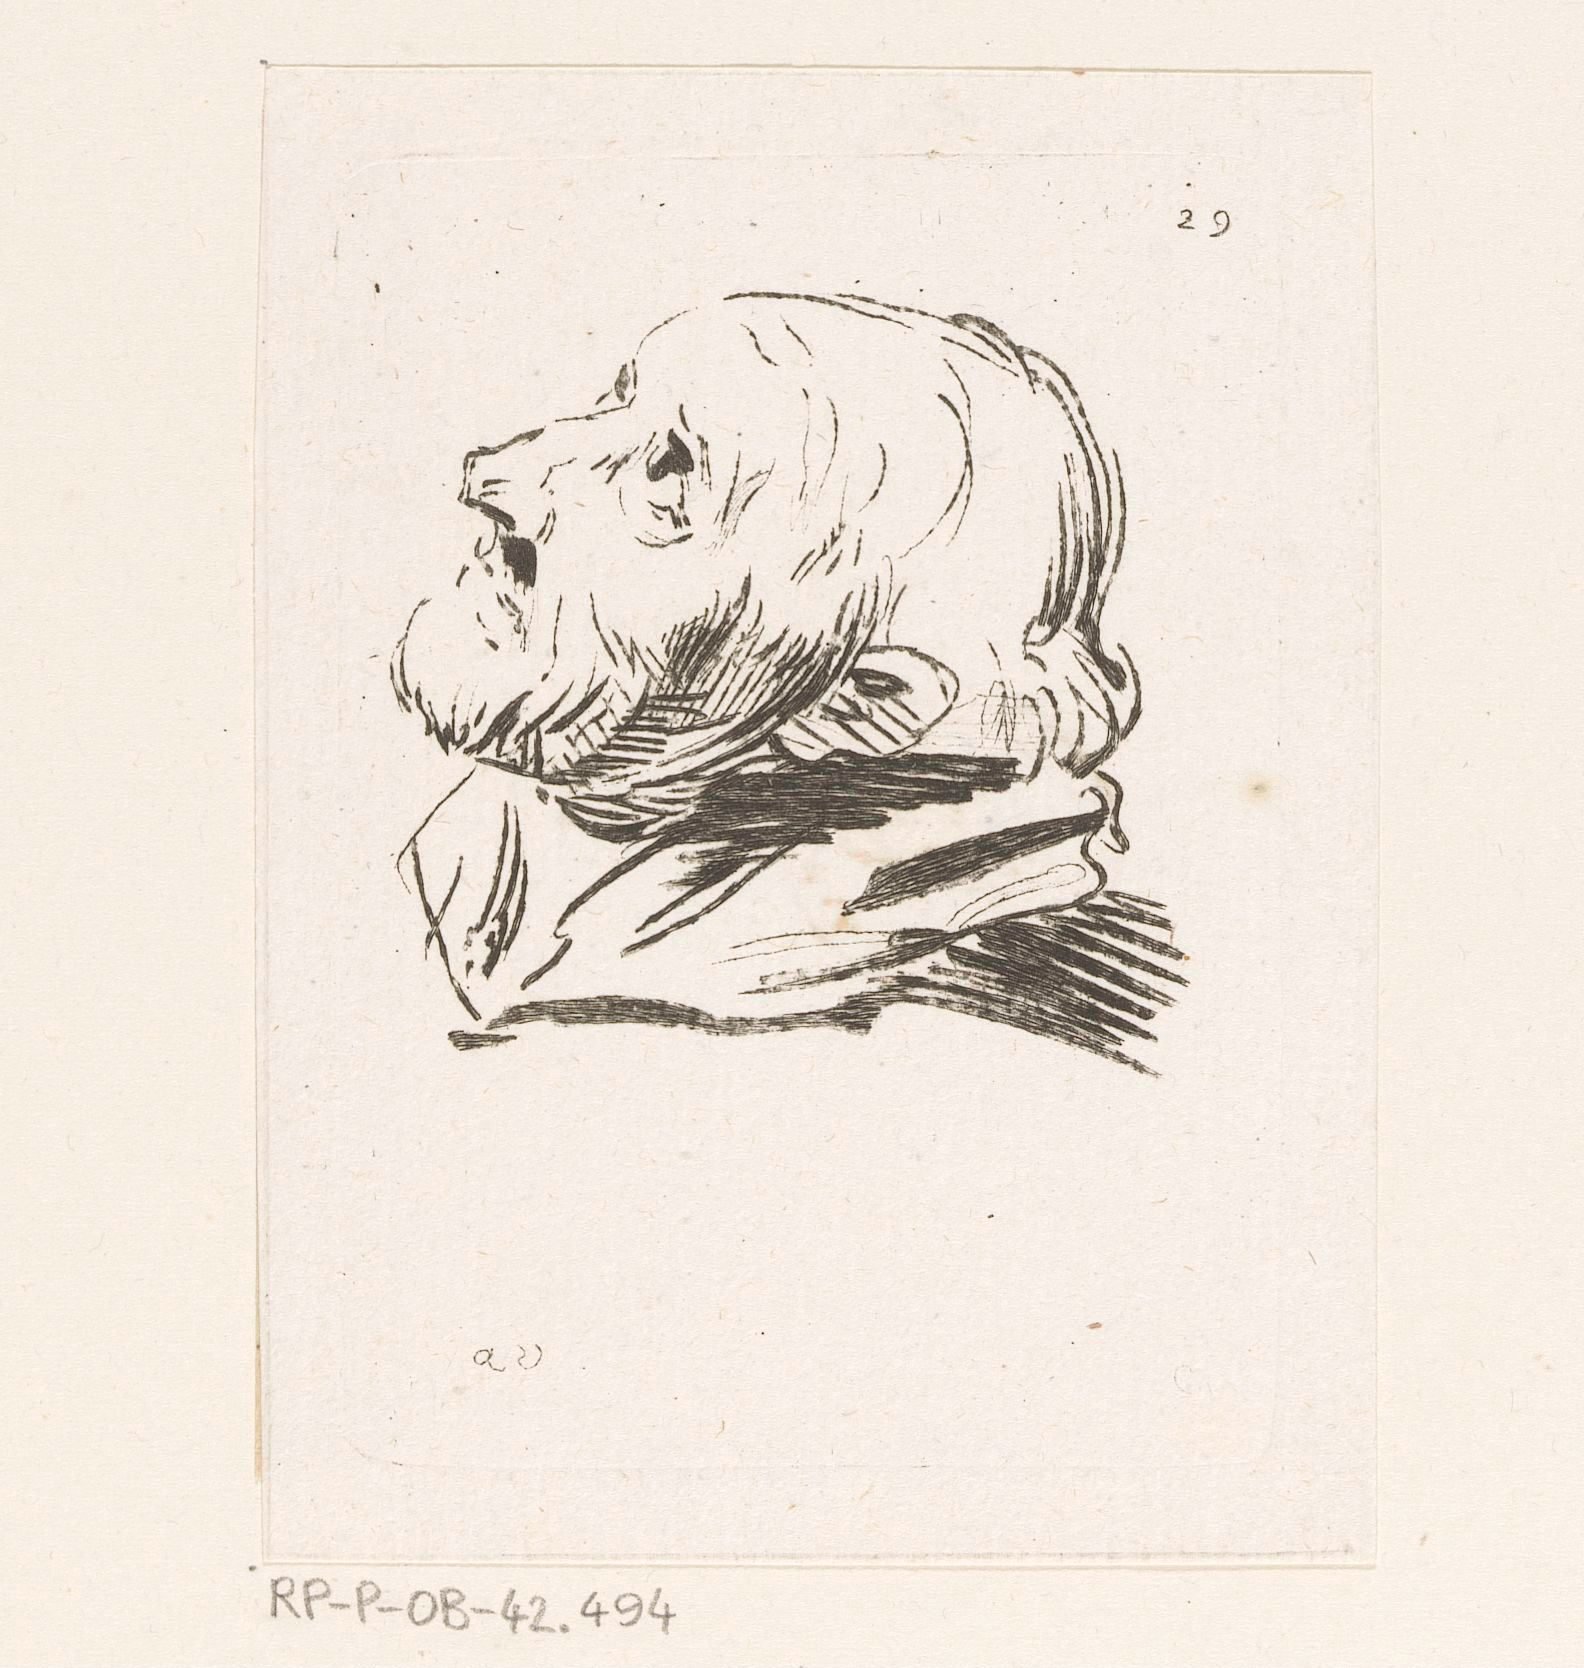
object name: print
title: Hoofd van een omhoog kijkende man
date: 1735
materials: paper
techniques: etching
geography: france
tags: head (human), beard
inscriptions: collector's mark: Lugt 240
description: Prent uit een serie van 31 prenten naar getekende hoofden door Van Dyck, plus een titelprent naar Bouchardon, getiteld: "Recueil de Testes d'Antoine Van Dyck tirées du Cabinet de M. Crozat et gravées par M. le C. de C.".